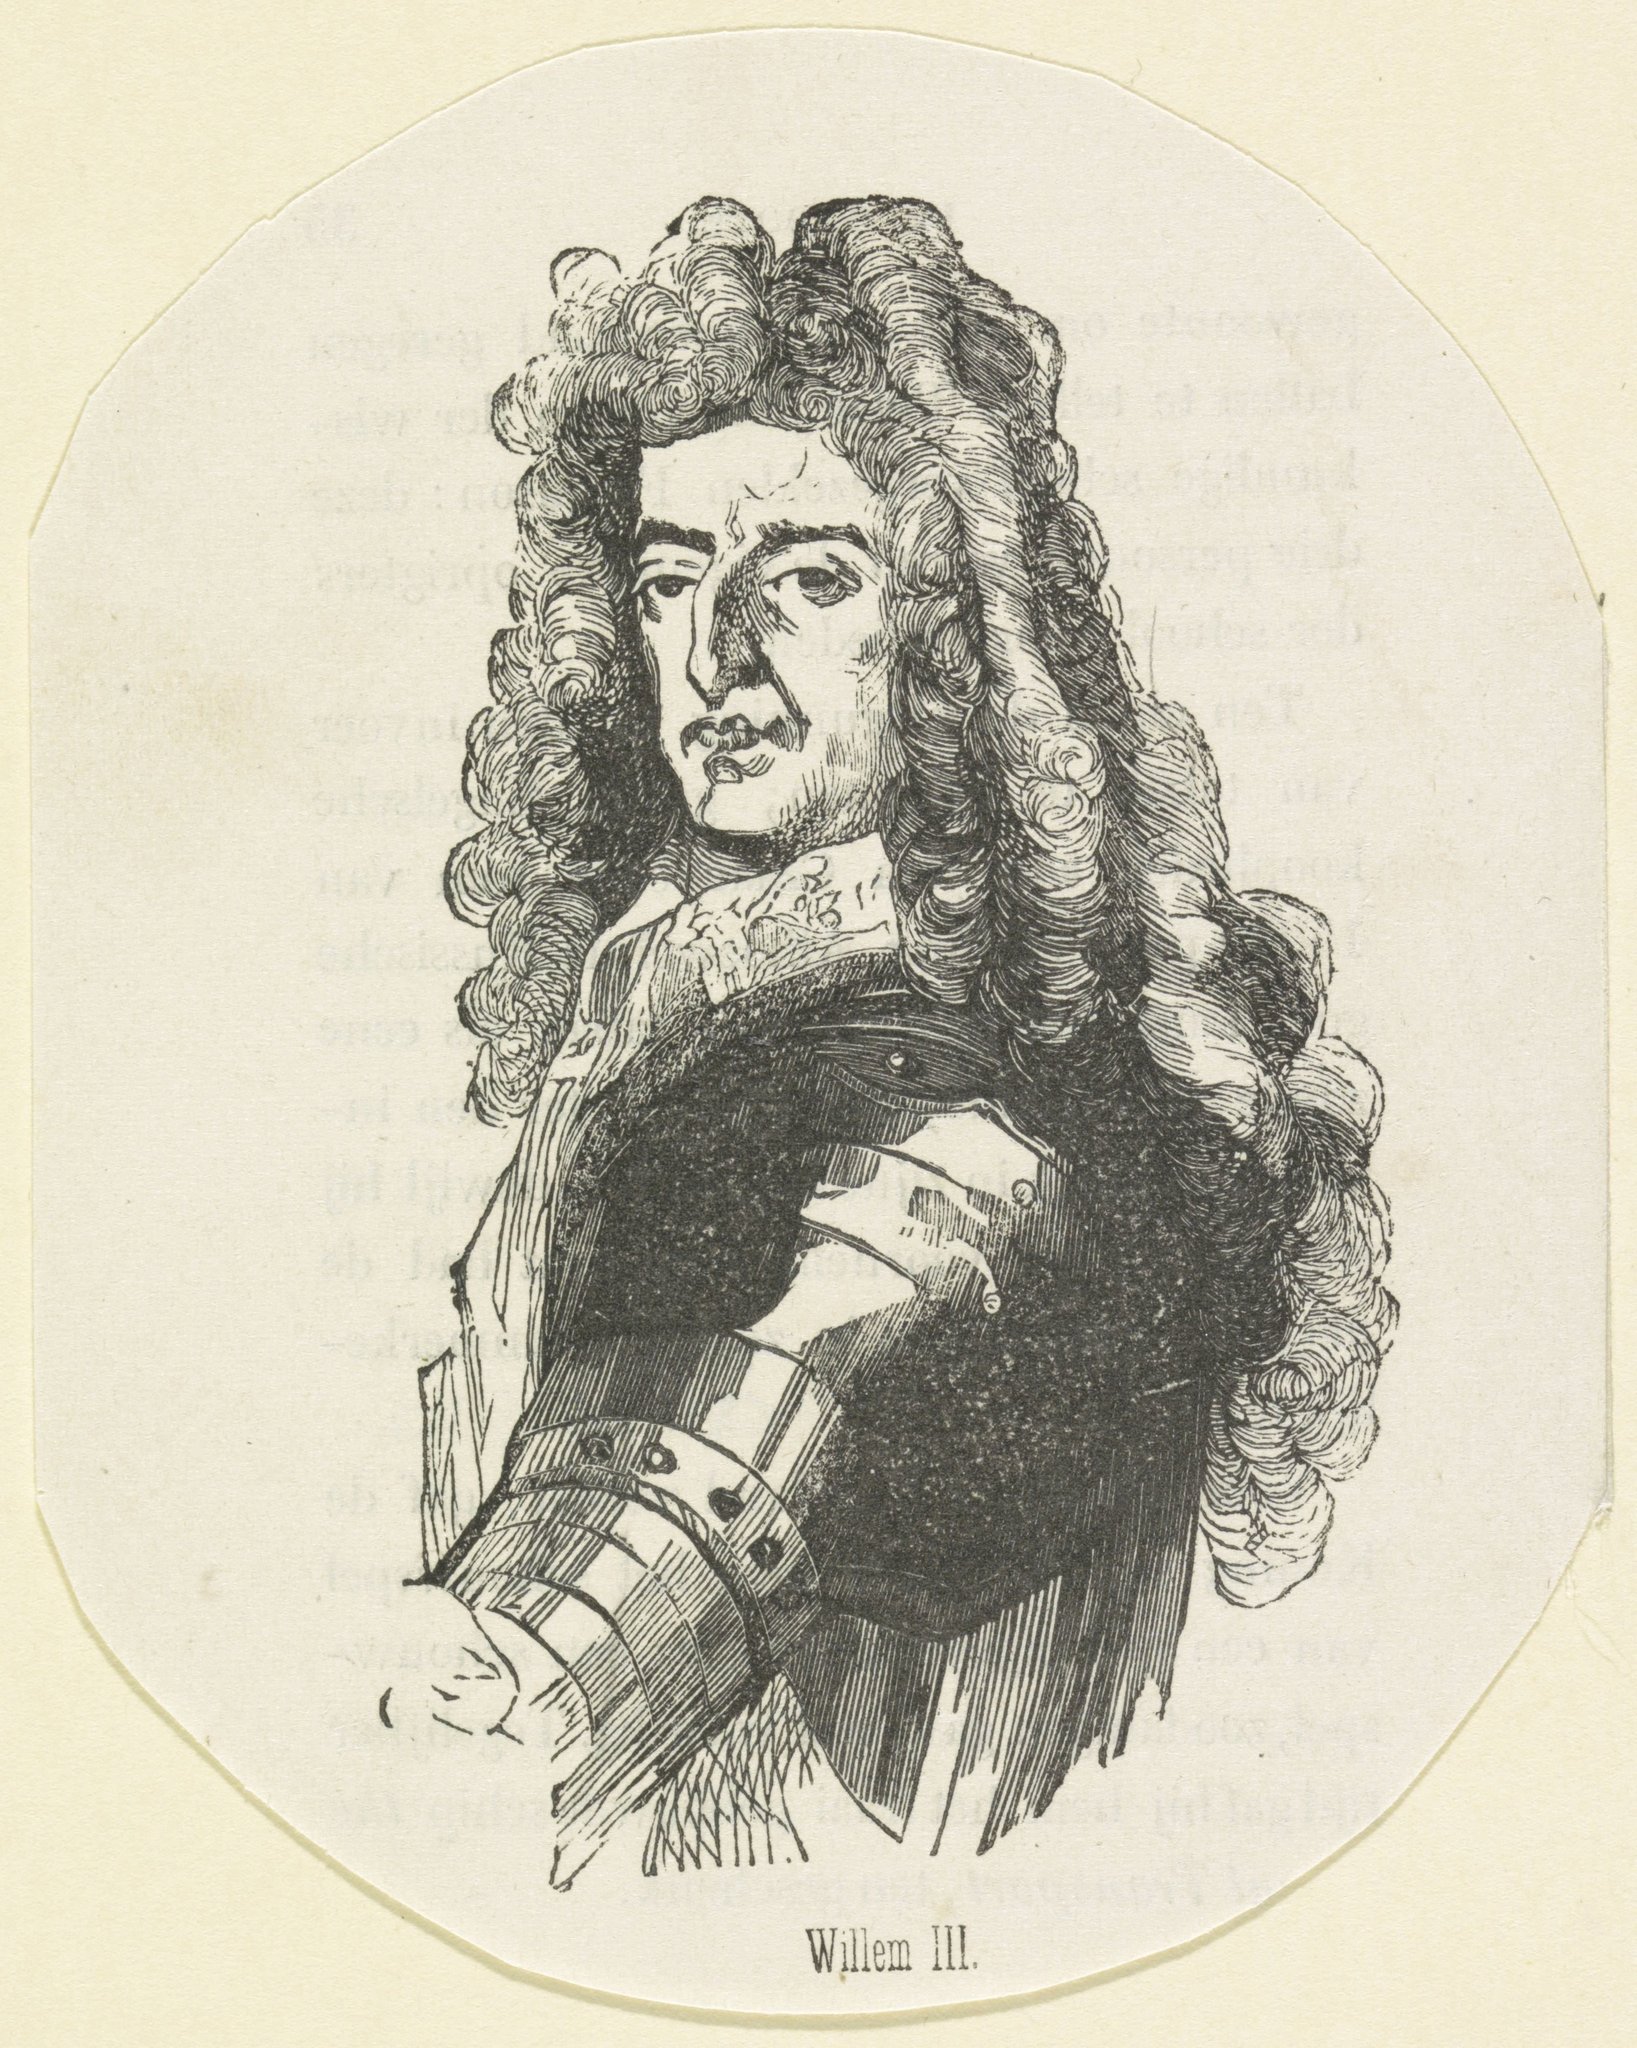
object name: print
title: Portret van Willem III, prins van Oranje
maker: Anonymous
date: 1800-1899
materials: paper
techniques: letterpress printing, engraving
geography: low countries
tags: the hague, william iii (prince of orange and king of england, scotland, and ireland)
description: De hier vermelde titel verwijst naar de hoogst verkregen titel van de geportretteerde, niet per se naar de titel die de geportretteerde op deze voorstelling draagt.